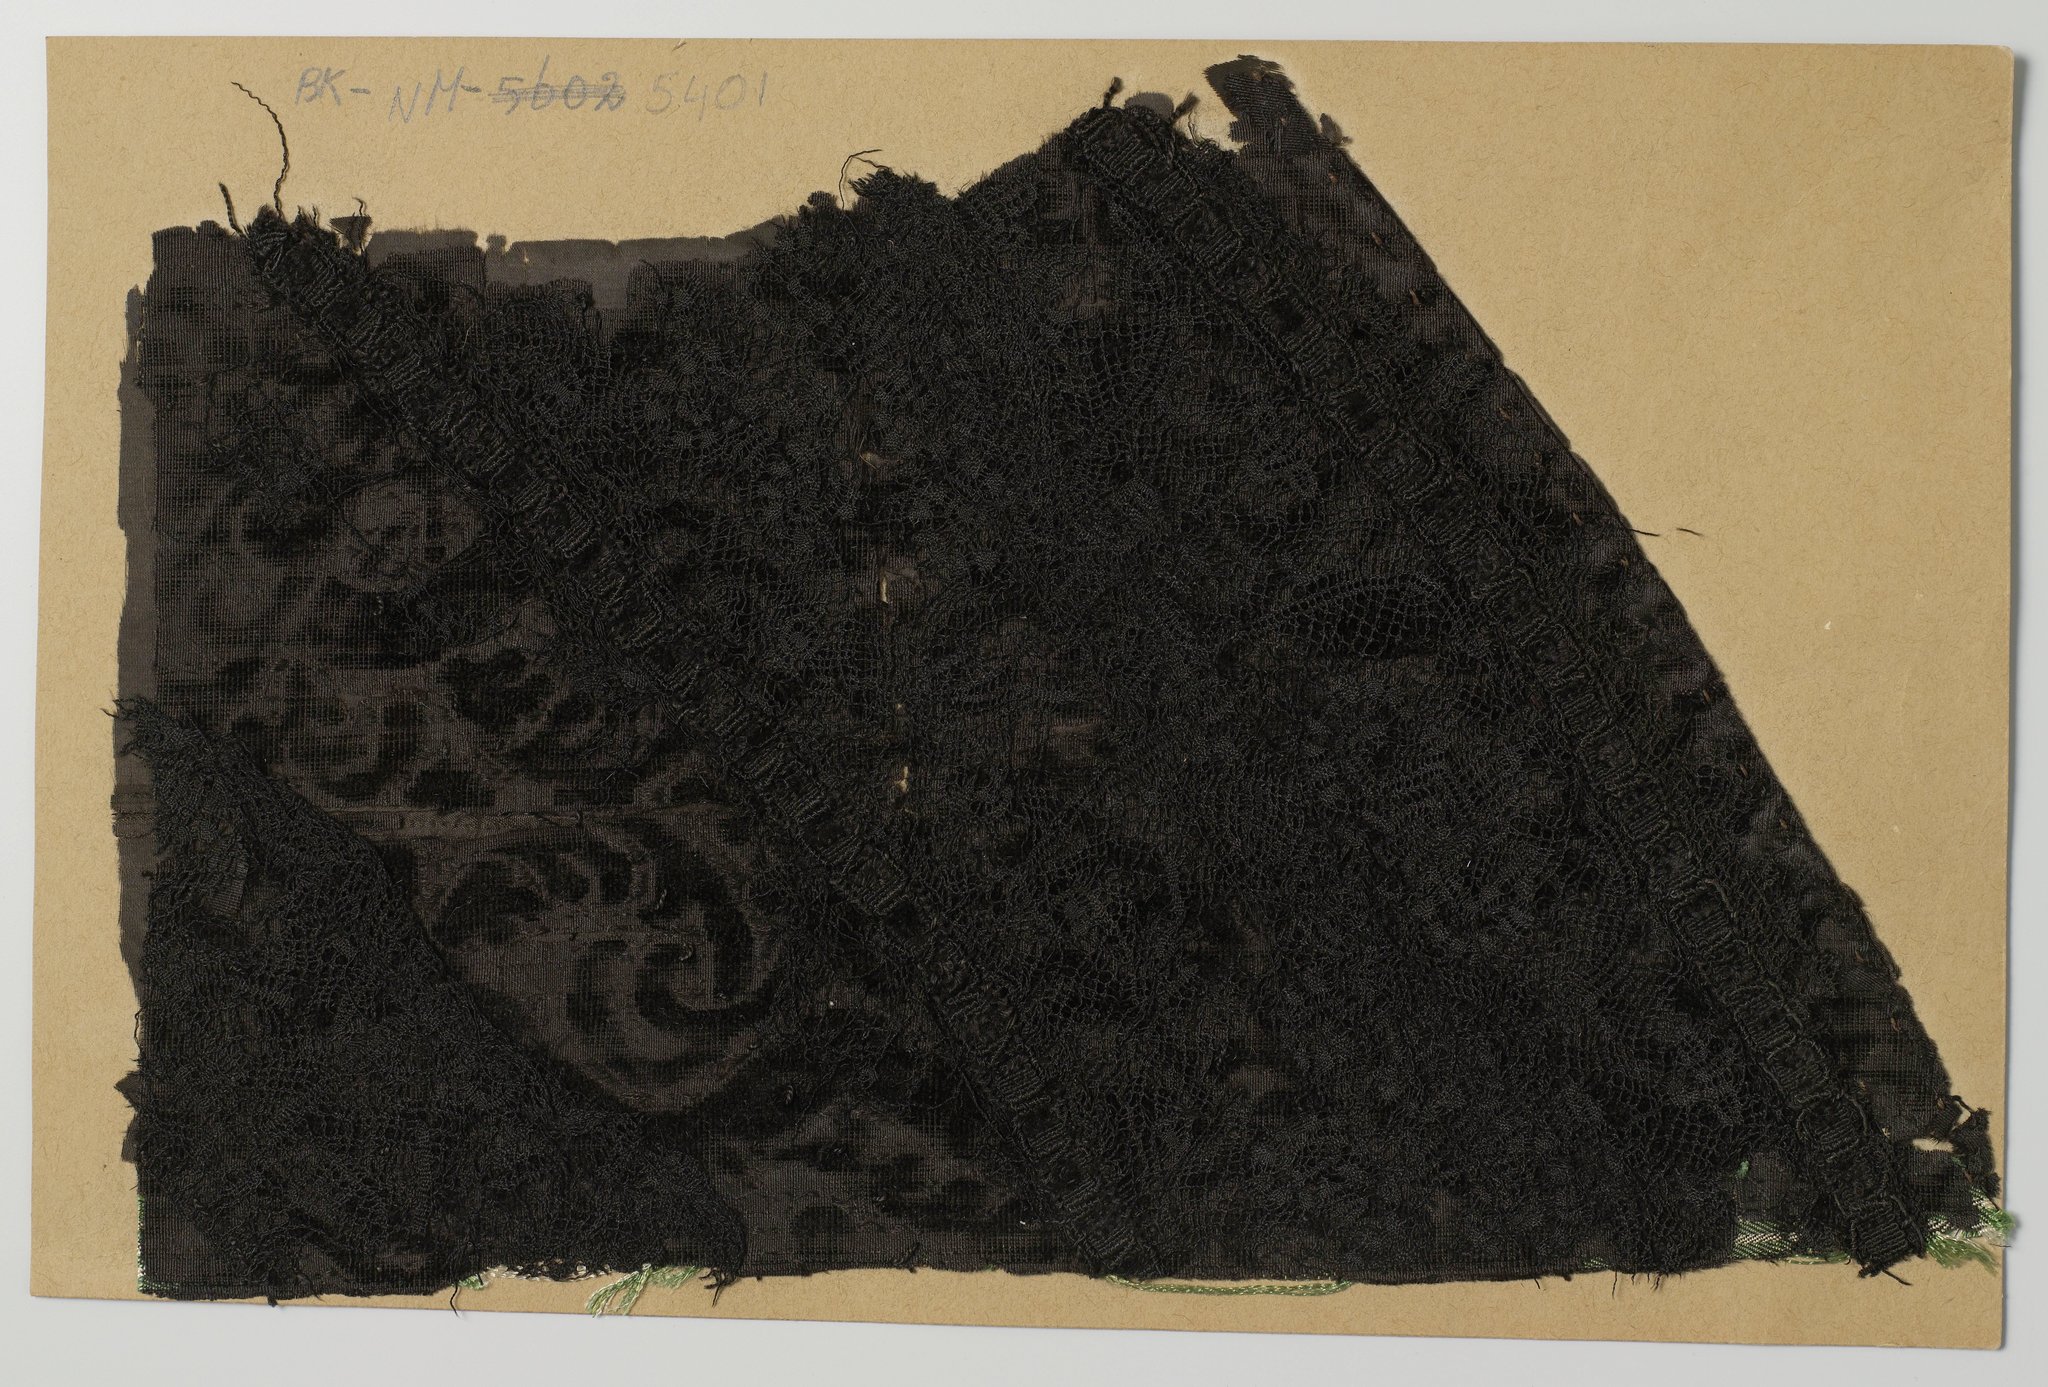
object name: mantle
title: Fragment van een mantel van ciseléfluweel met kloskant, volgens overlevering afkomstig van Hugo de Groot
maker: Anonymous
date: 1600-1699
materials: silk, velvet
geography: netherlands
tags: delft, hugo de groot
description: Fragment van een mantel van zwarte ciseléfluweel waarop zwarte kloskant is genaaid. Het fragment is volgens overlevering afkomstig van een mantel van Hugo de Groot.